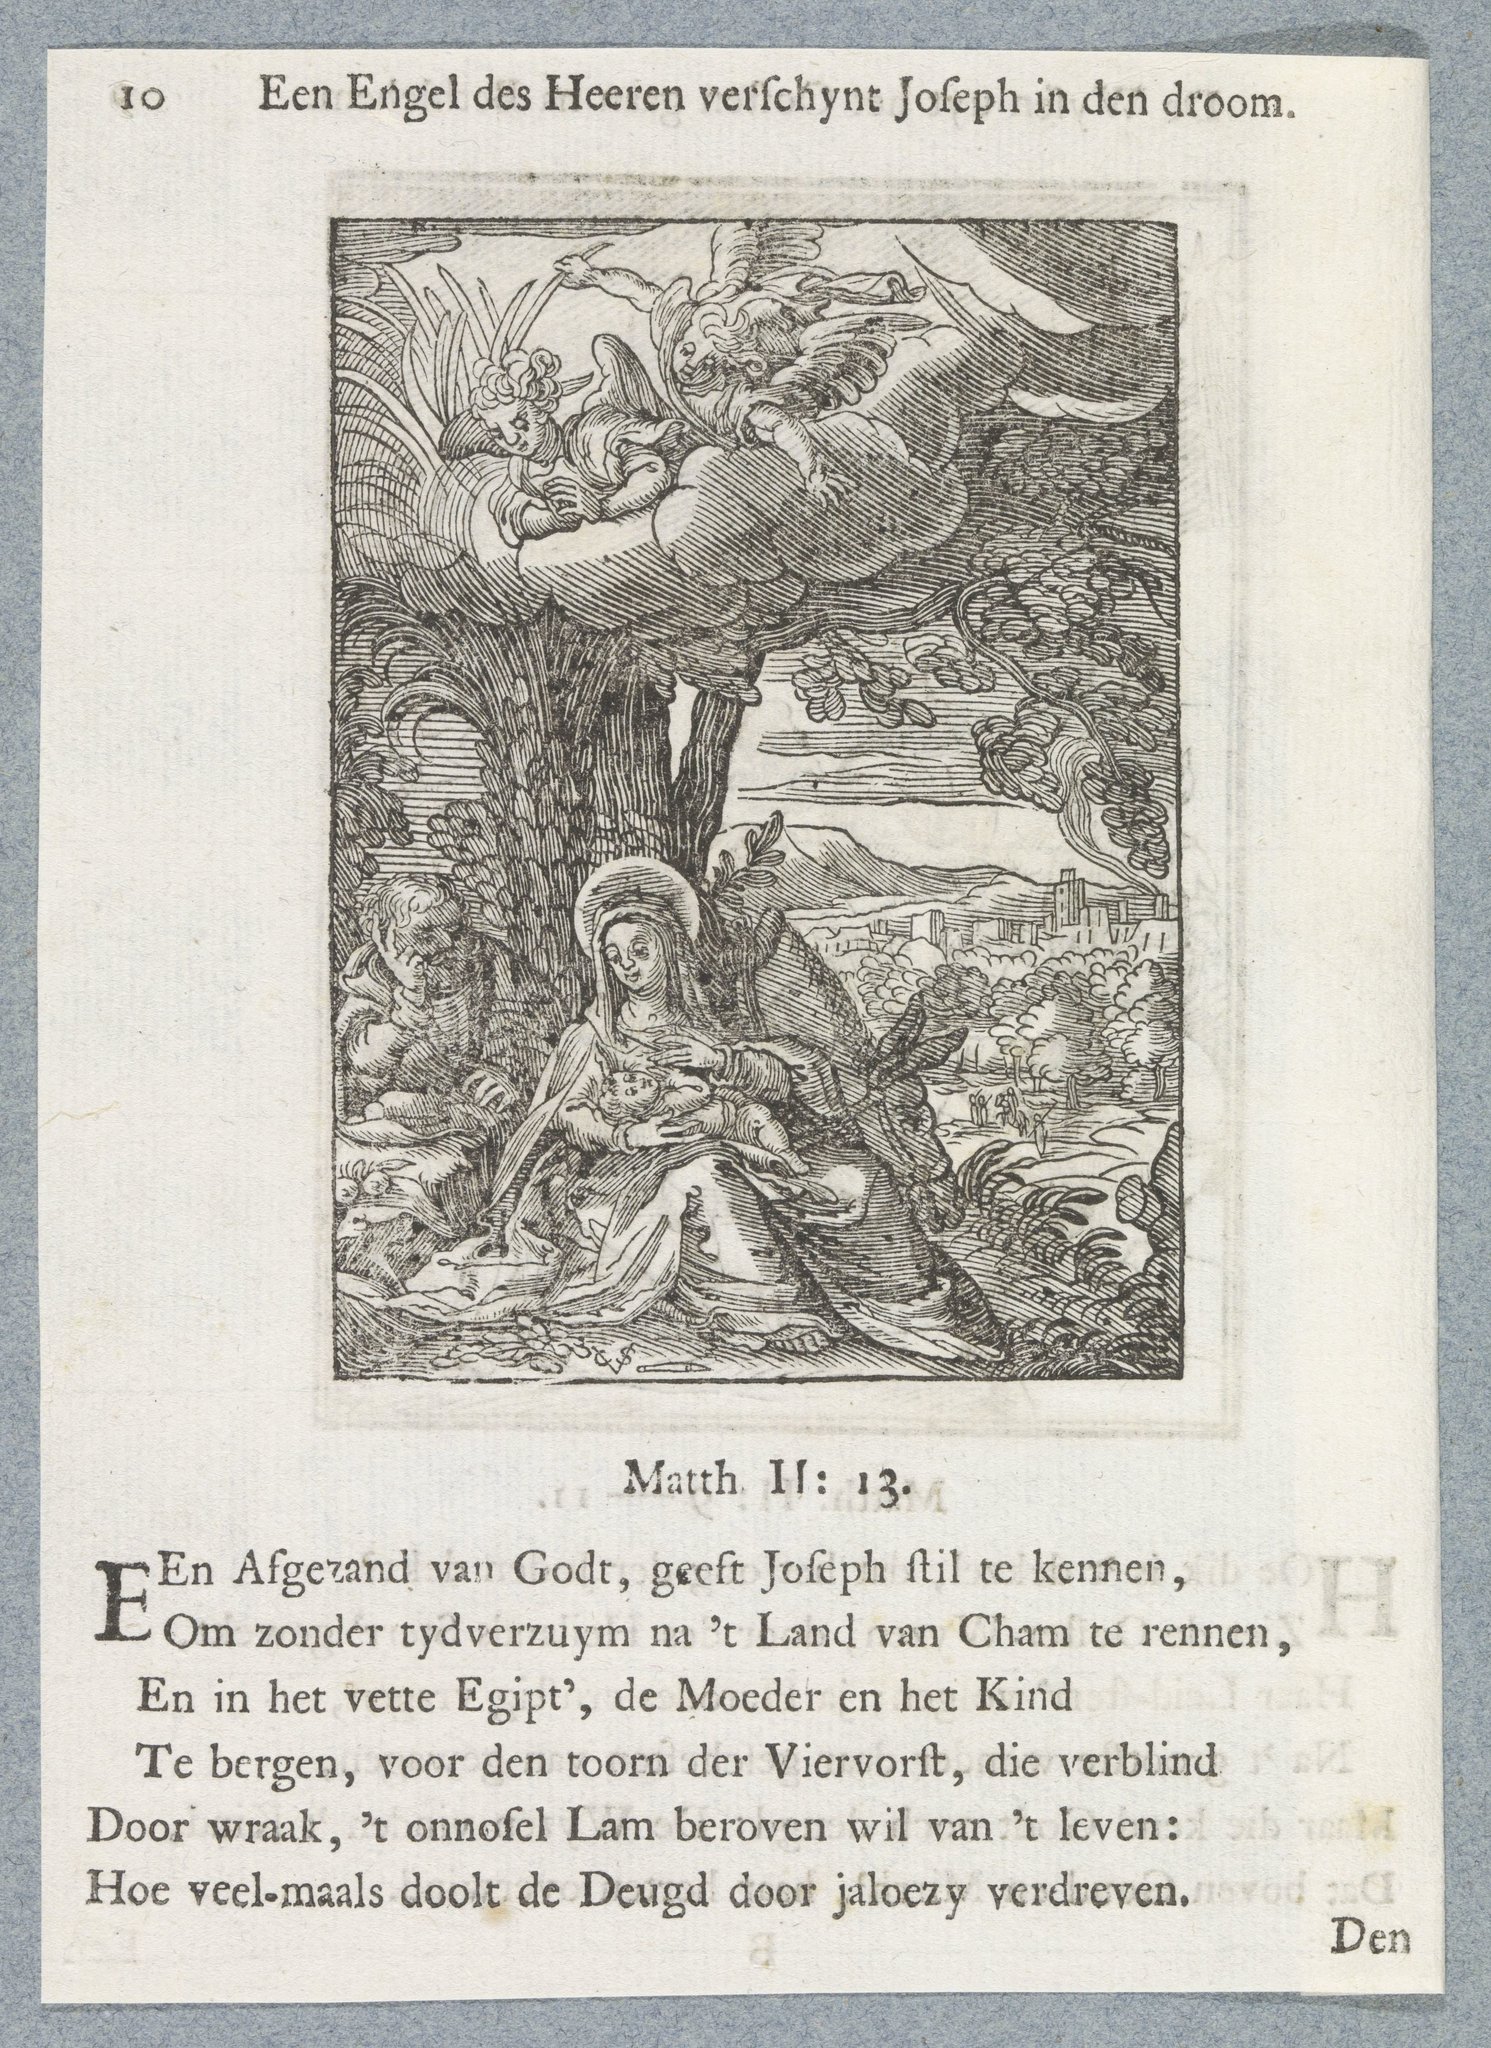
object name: album leaf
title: Rust op de vlucht naar Egypte met engelen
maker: jan klooster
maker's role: bookseller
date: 1629-1648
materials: paper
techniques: letterpress printing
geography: amsterdam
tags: rest on the flight into egypt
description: Heilige Familie rustend op de tocht naar Egypte. Maria voedt het Christuskind onder een palmboom. Bovenin de wolken twee engelen. Rechts een landschap. Boven de voorstelling een titel. Eronder zes versregels en een verwijzing naar Mattheüs 2: 13. De prent maakt deel uit van een album.